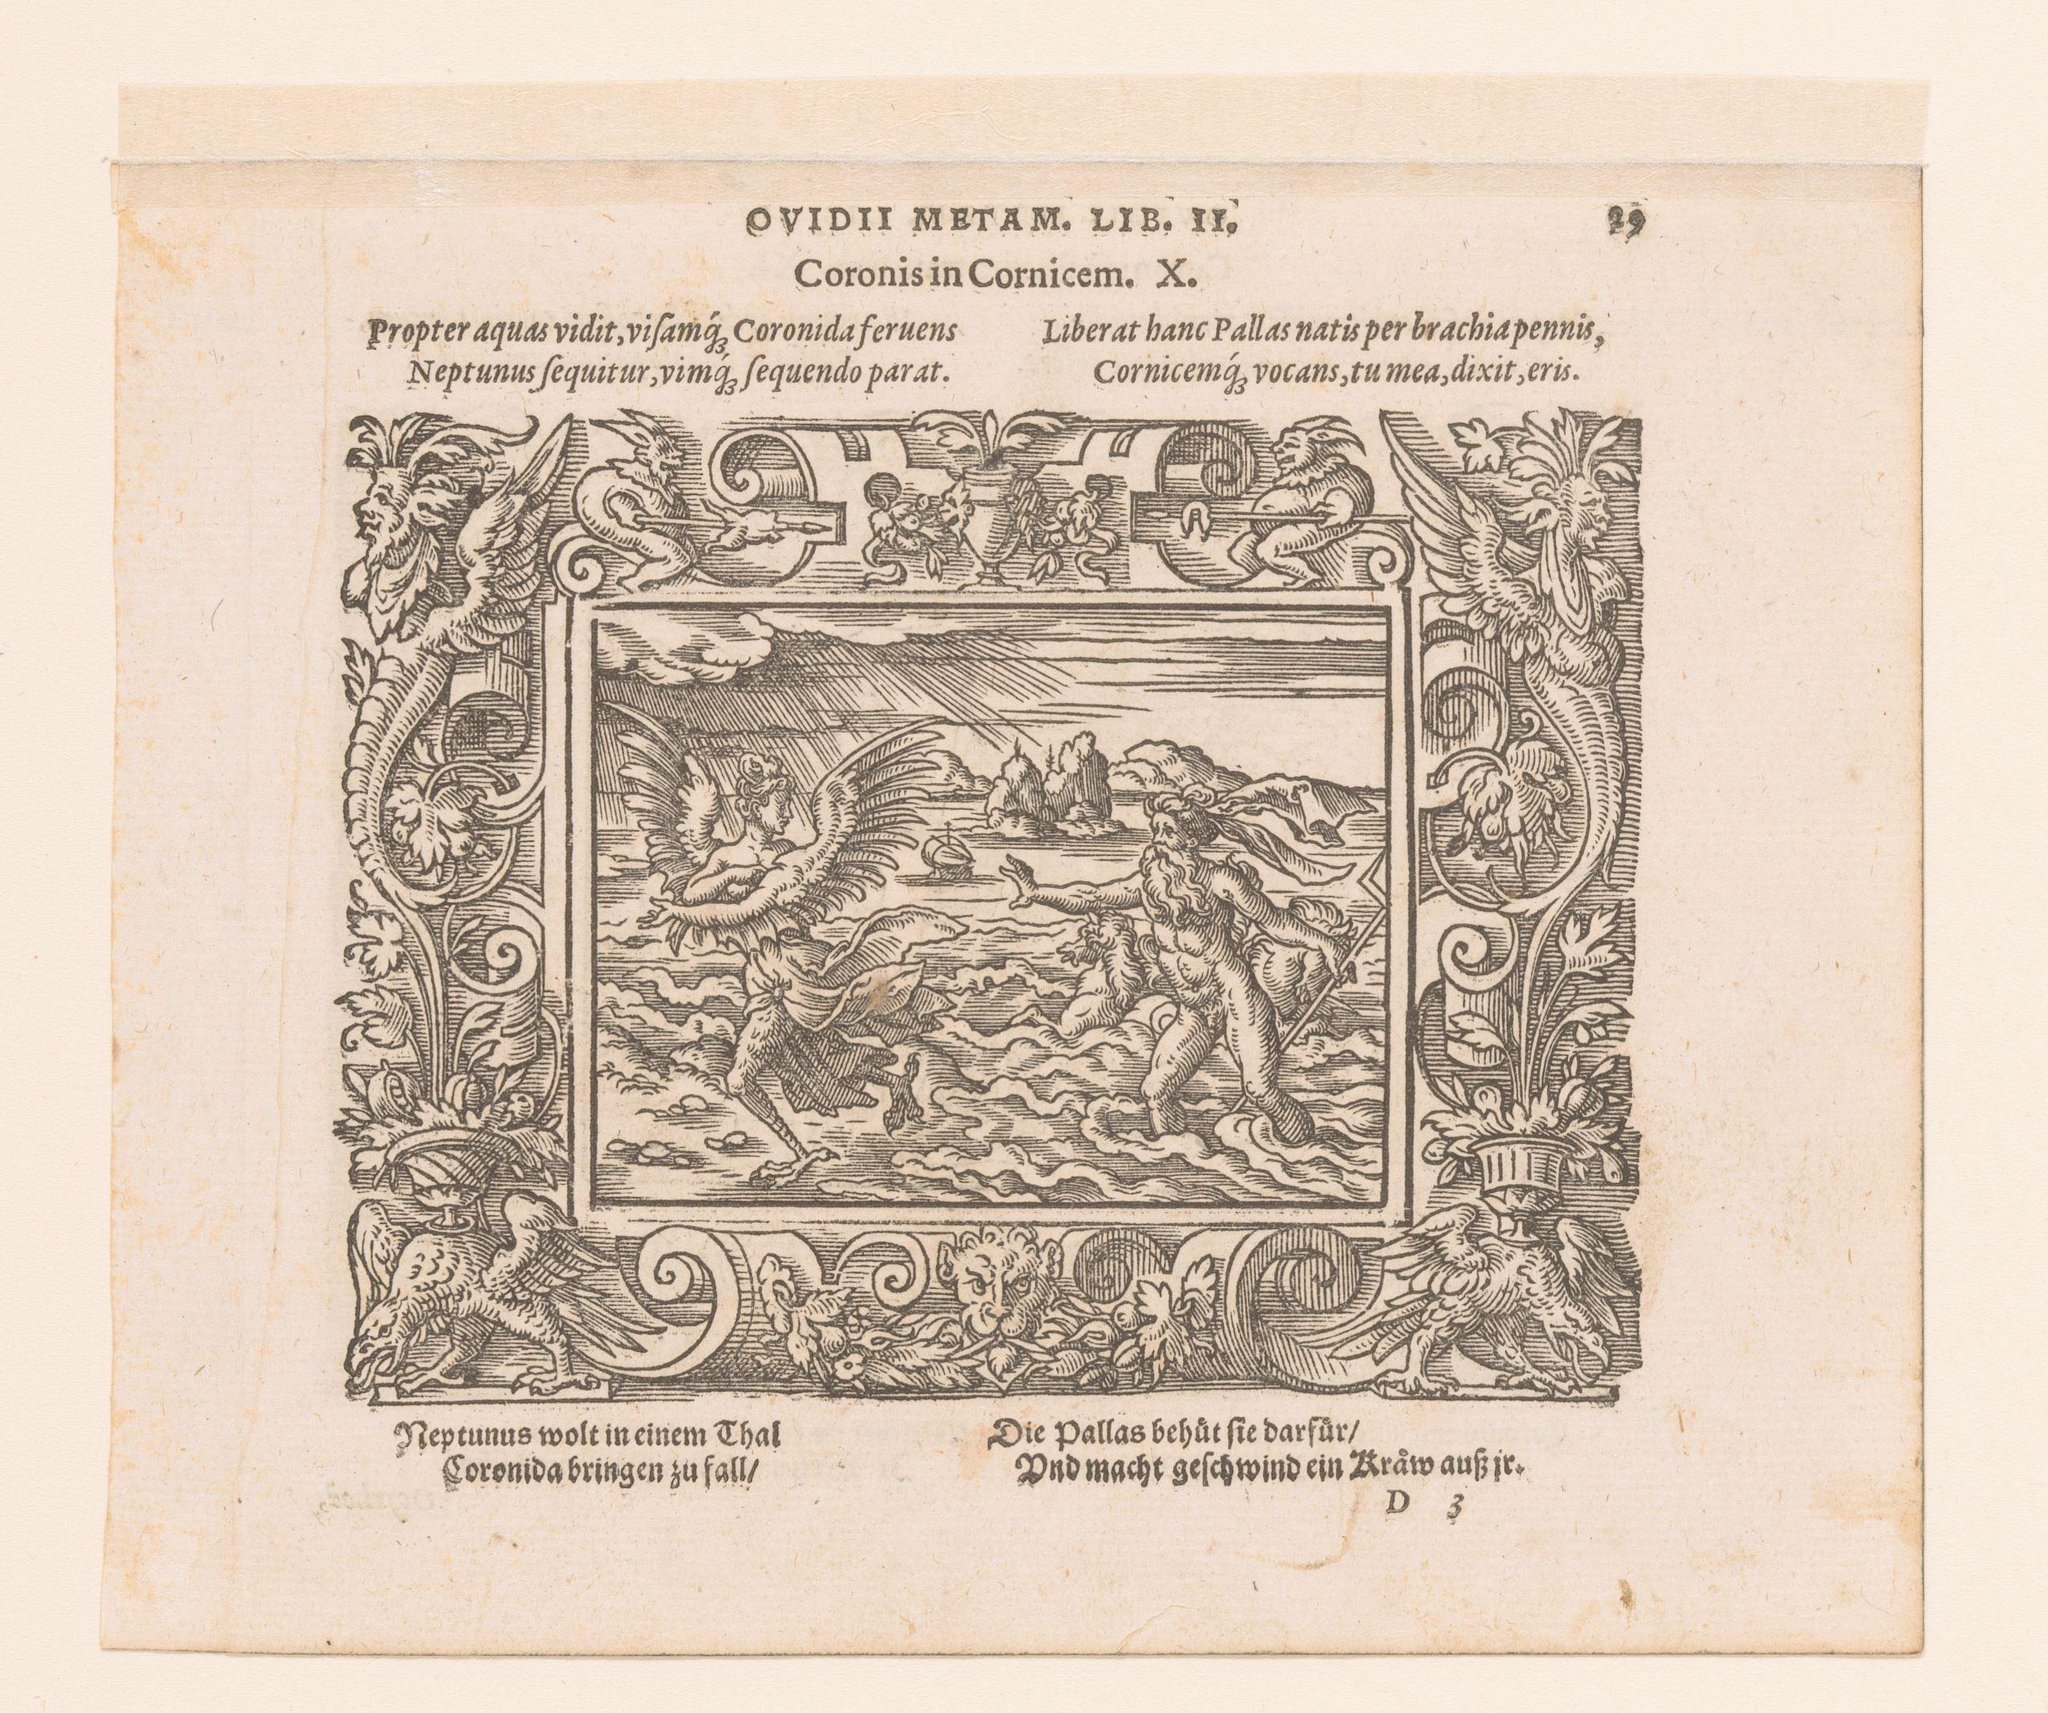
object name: print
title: Coronis in Cornicem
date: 1569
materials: paper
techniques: letterpress printing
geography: frankfurt am main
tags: scrollwork, strapwork ~ ornament, coronis changed into a crow: to escape the love of neptune, coronis, daughter of coroneus, is changed into a crow by minerva (ovid, metamorphoses ii 569)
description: Illustratie bij de Metamorfosen van Ovidius, afkomstig uit de publicatie: Posthius, Johannes. Tetrasticha in Ovidii metam. Frankfurt am Main: Georg Rab en Sigmund Feyerabend en erven Weigand Han, 1569. De voorstellingen en ornamentranden van deze boekillustraties zijn van twee aparte blokken gedrukt. Beide werden afzonderlijk van elkaar ook gebruikt voor andere publicaties, en de ornamentranden werden eveneens binnen deze publicatie meerdere keren gebruikt.